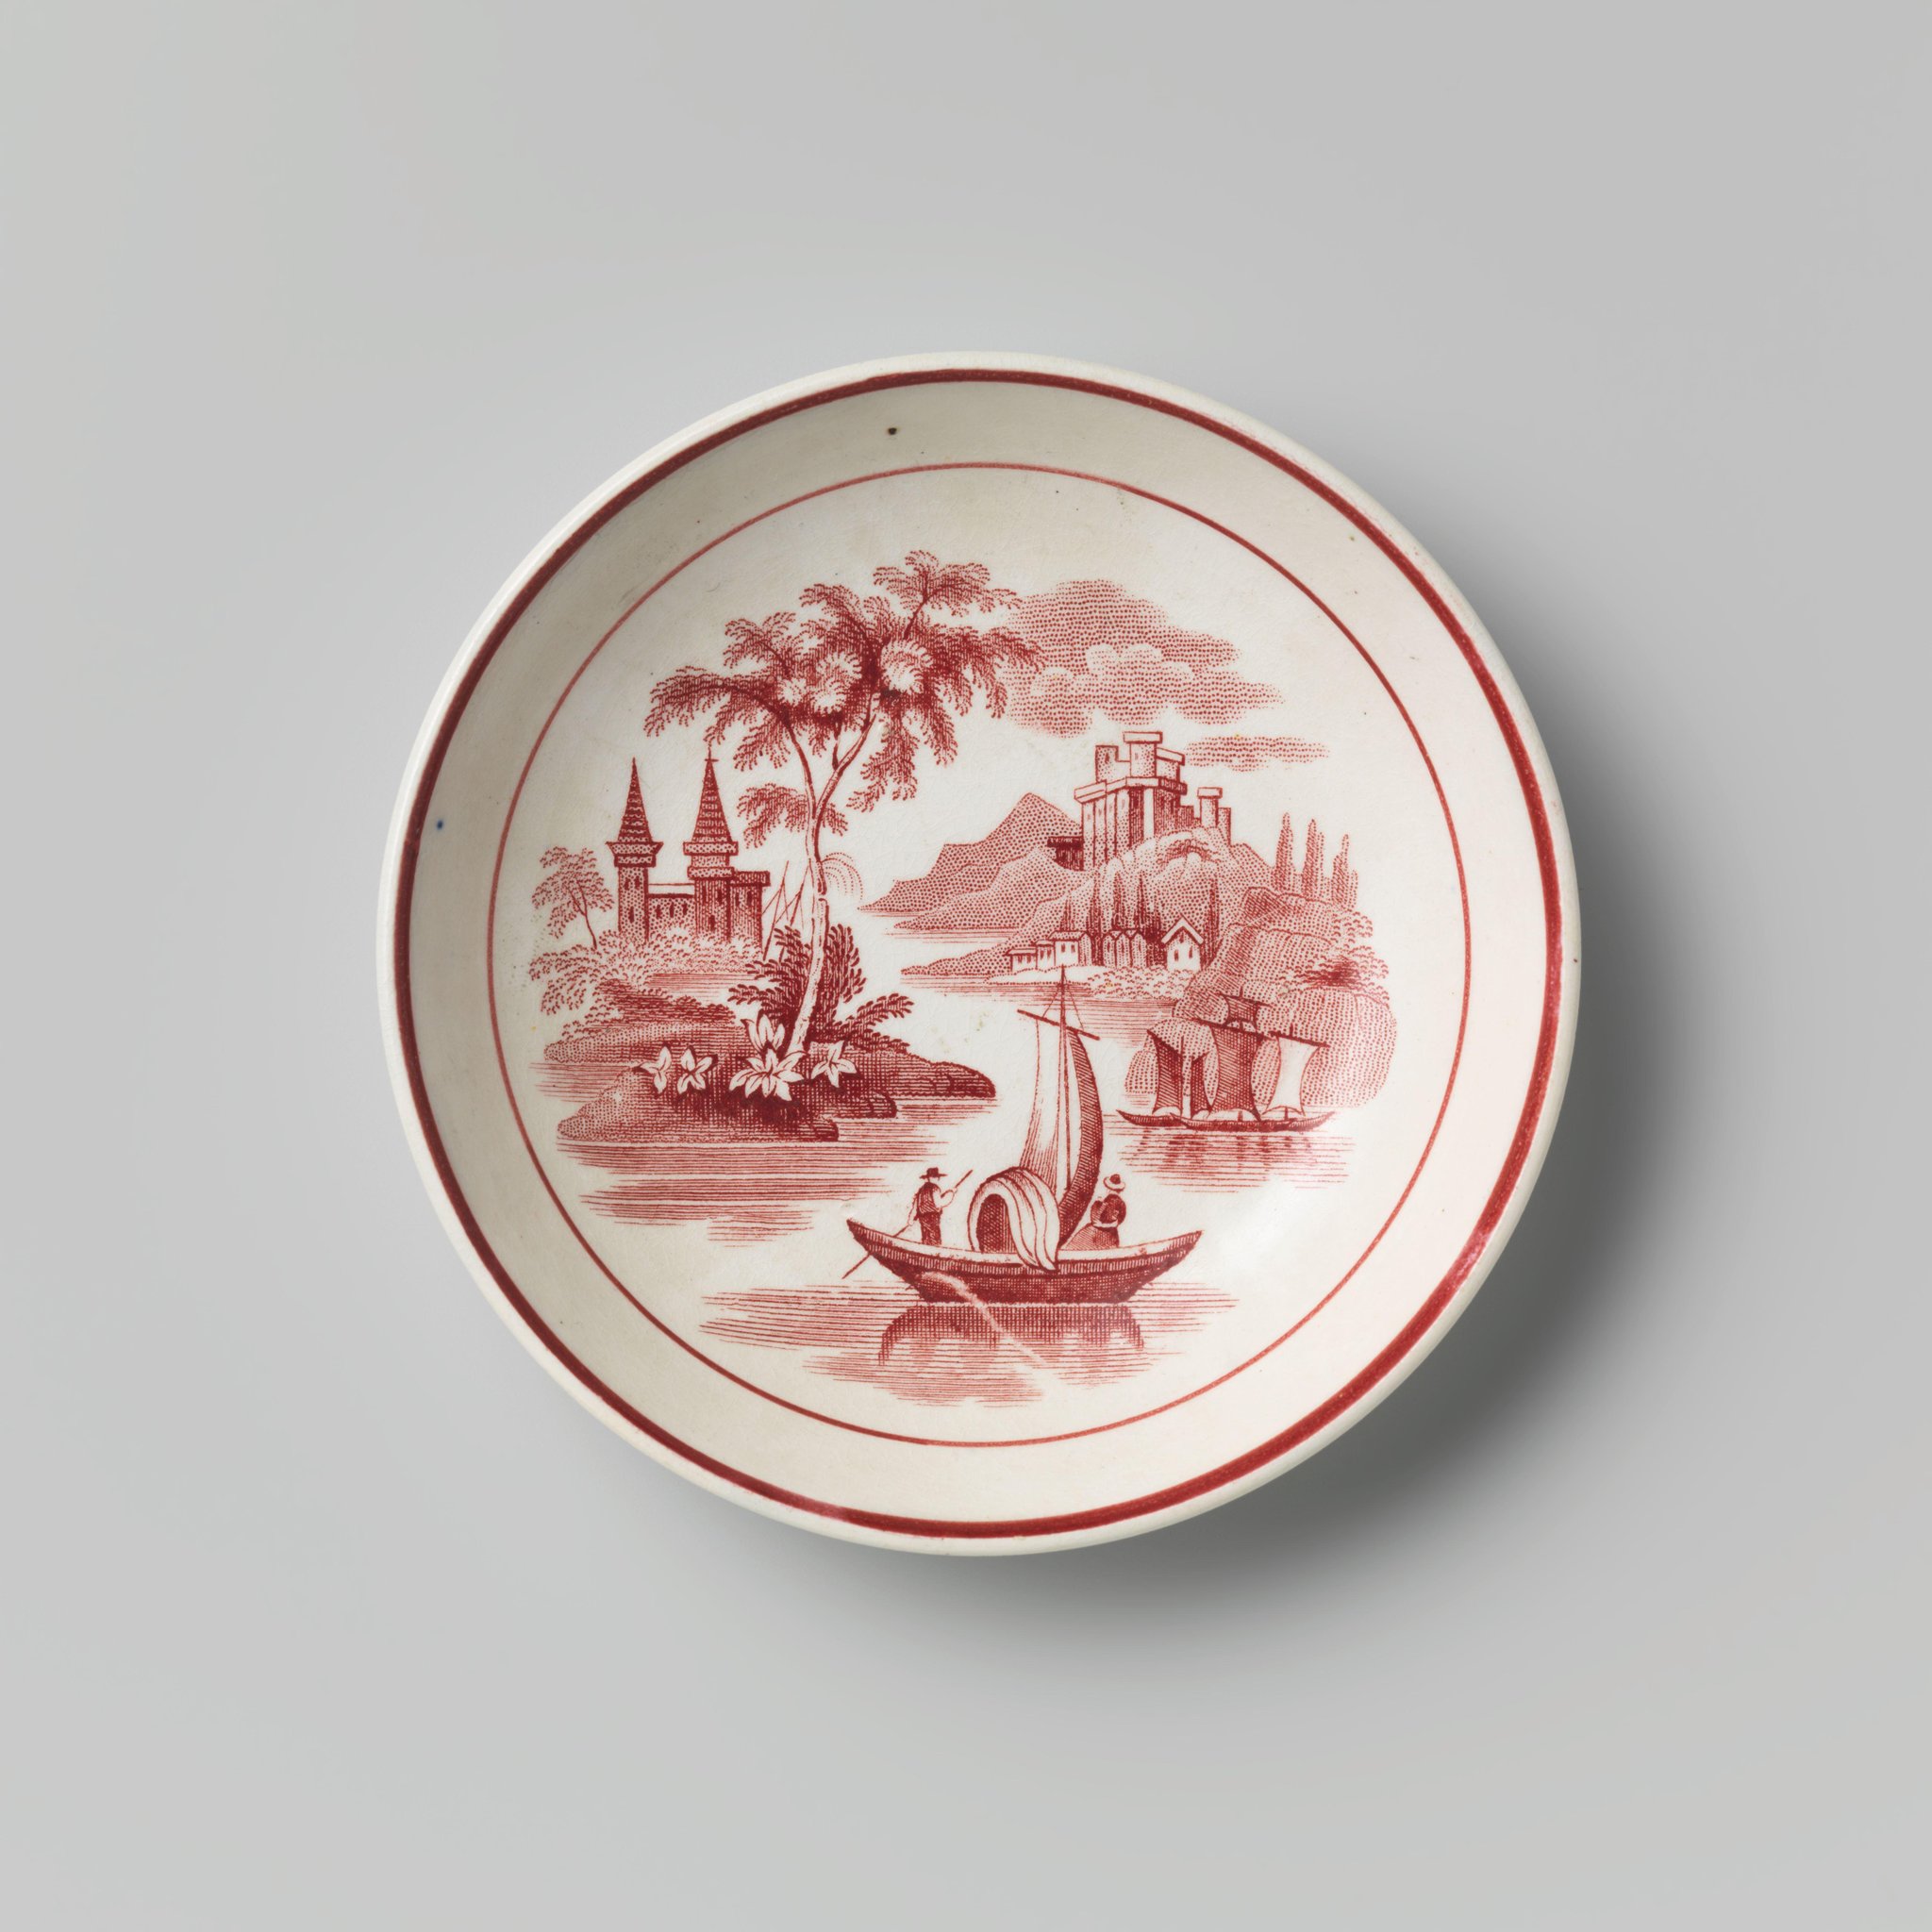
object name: platter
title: Schotel, gedecoreerd met binnenwater met schepen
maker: petrus regout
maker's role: plateelbakker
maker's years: 1801-1879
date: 1850-1875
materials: creamware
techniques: transfer decoration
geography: maastricht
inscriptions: mark: ‘Staffordshire knot // 1851 // PRIZE MEDAL // FANCY // P.REGOUT’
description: Schotel van aardewerk met rood transferdecor, rond, met een binnenwater met schepen. De opstaande rand met twee biezen.